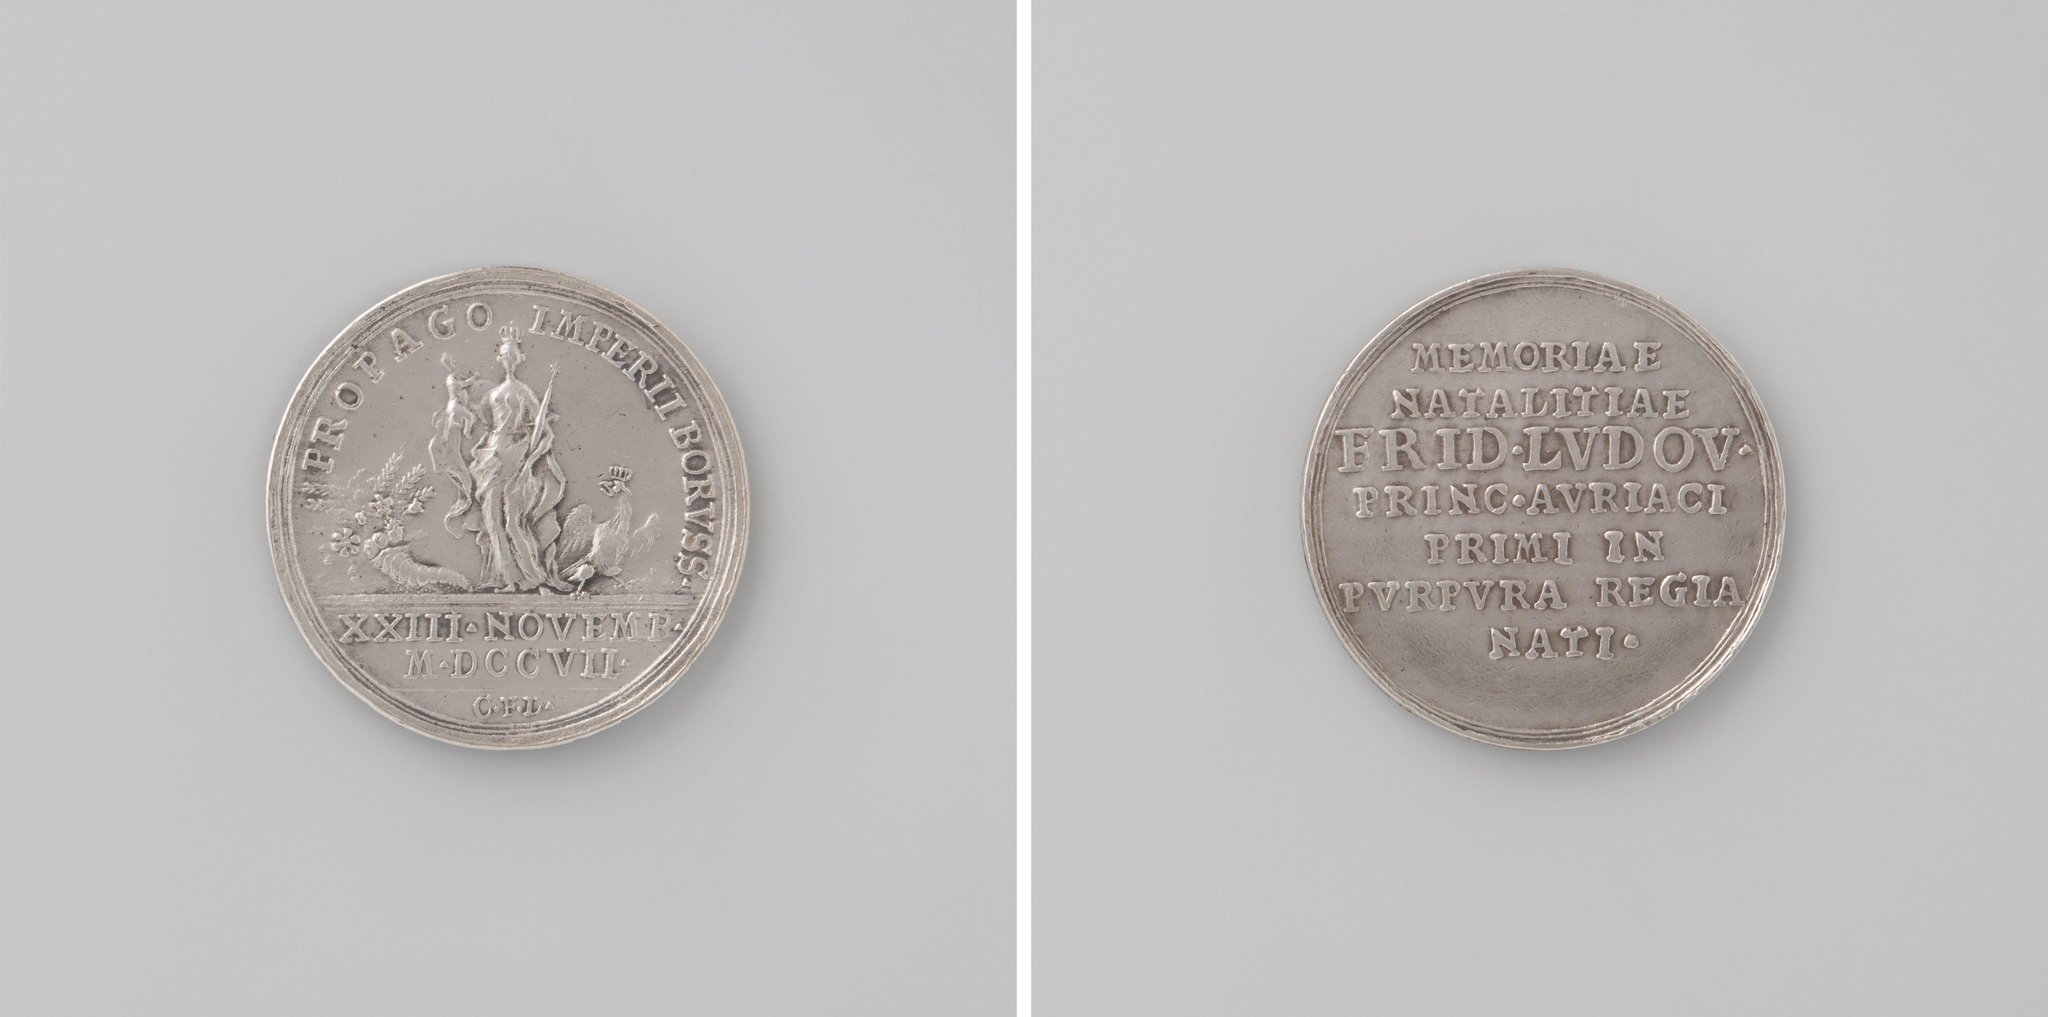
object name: jeton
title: Geboorte van Frederik Lodewijk van Pruisen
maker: christian friedrich lüders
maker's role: muntmaker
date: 1707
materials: silver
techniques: striking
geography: berlin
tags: frederik lodewijk (erfprins van pruisen)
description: Zilveren penning. Voorzijde: Pruisen in gedaante van gekroonde vrouw met kind op arm staande tussen hoorn van overvloed en arend binnen omschrift; afsnede: opschrift. Keerzijde: opschrift